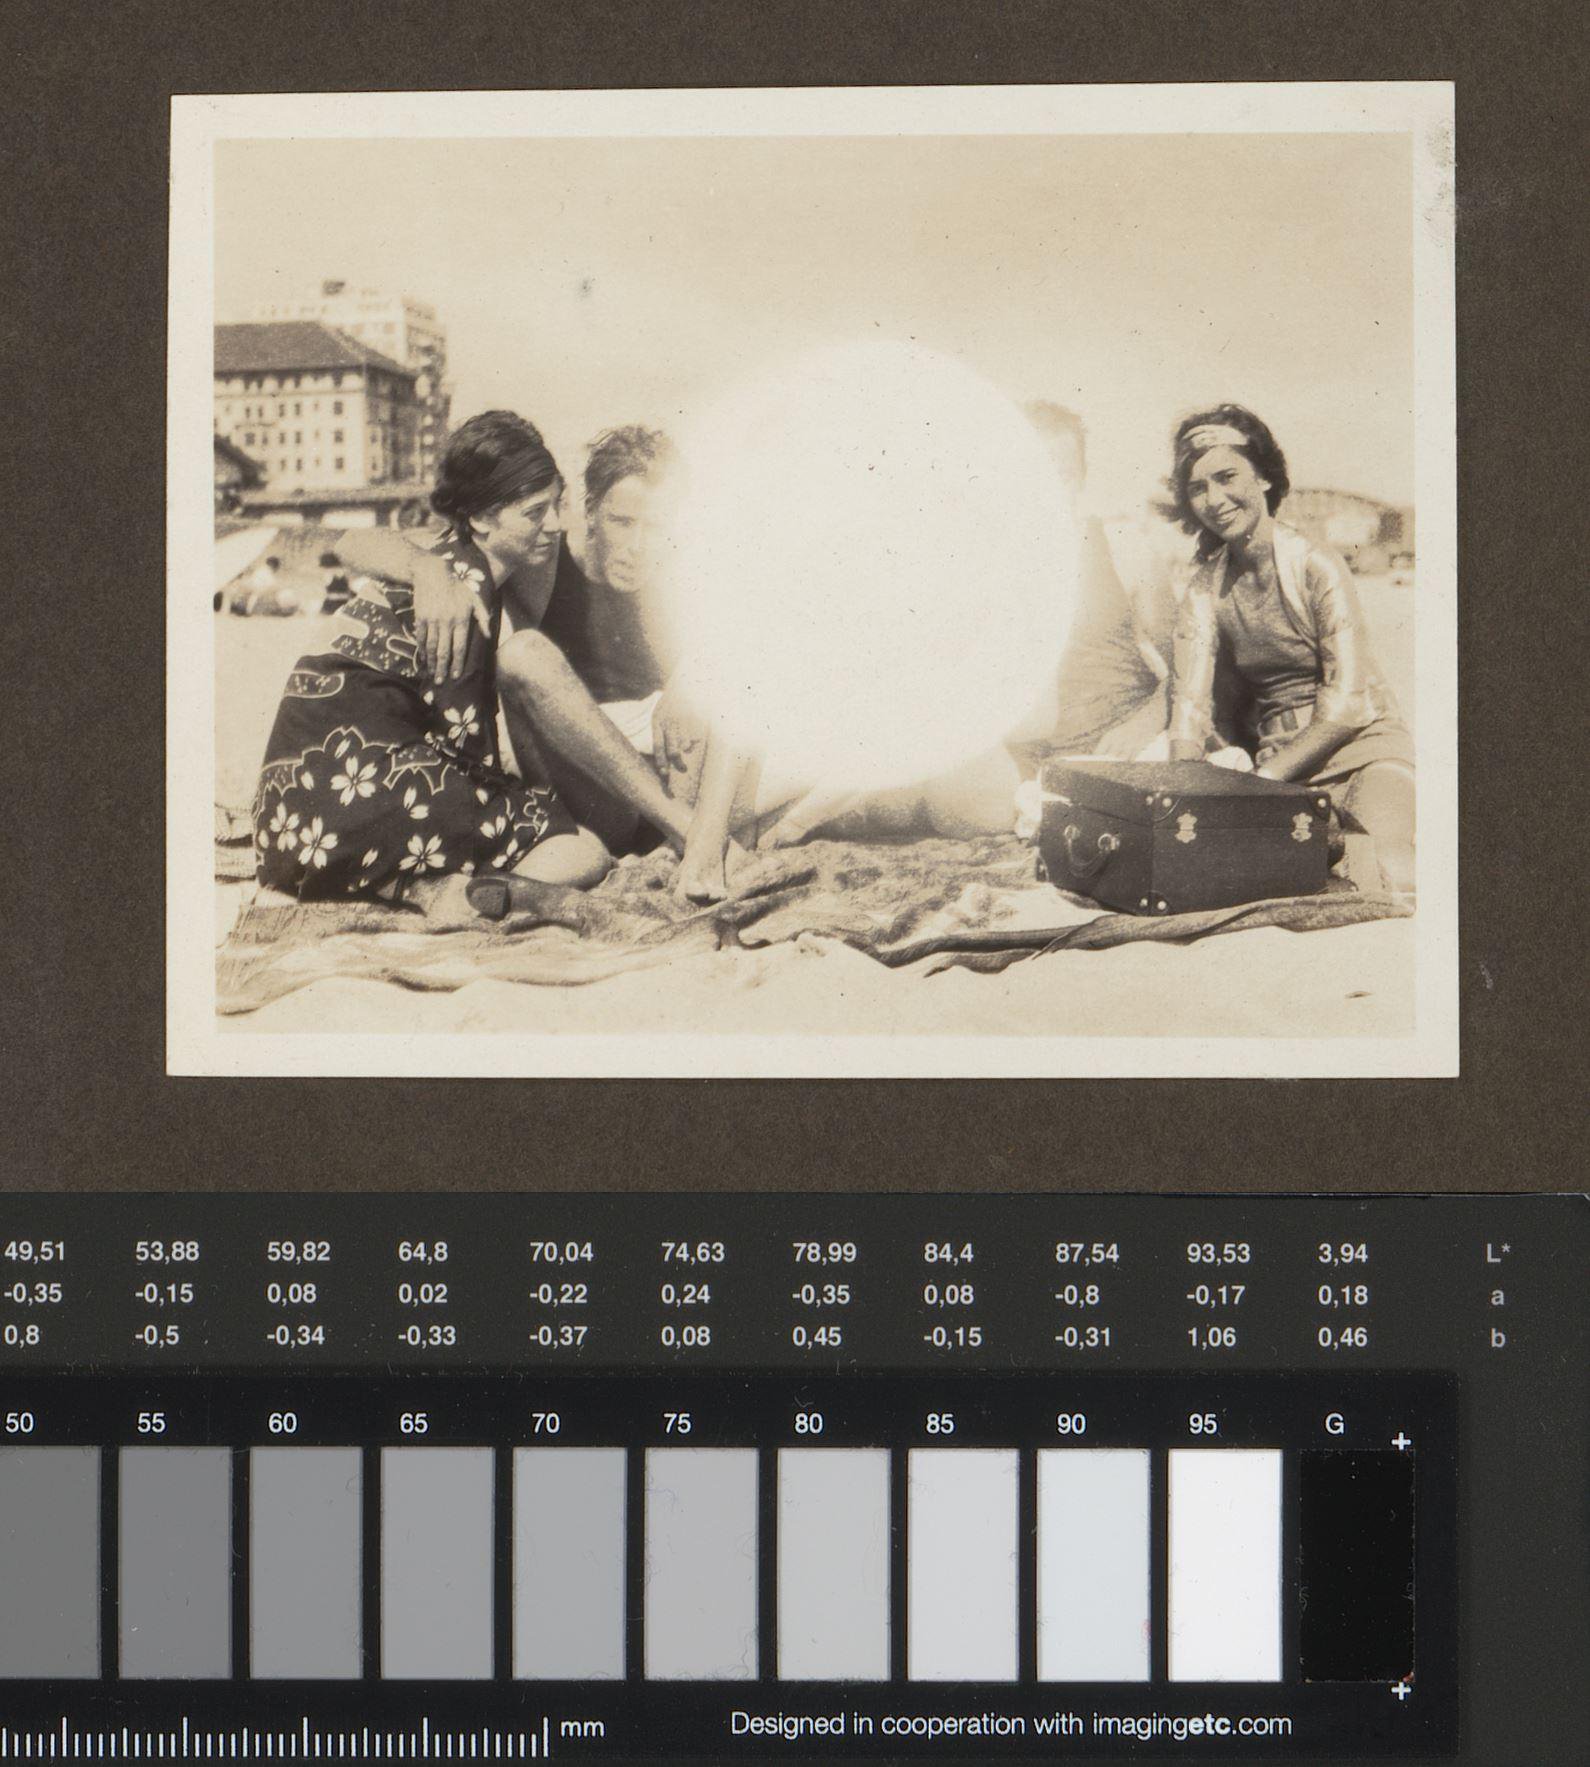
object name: photograph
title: Mannen en vrouwen op het strand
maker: Anonymous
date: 1928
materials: photographic support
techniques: gelatin silver print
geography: long beach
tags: adult woman, adult man, historical persons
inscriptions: annotation: ‘Strand Long Beach’